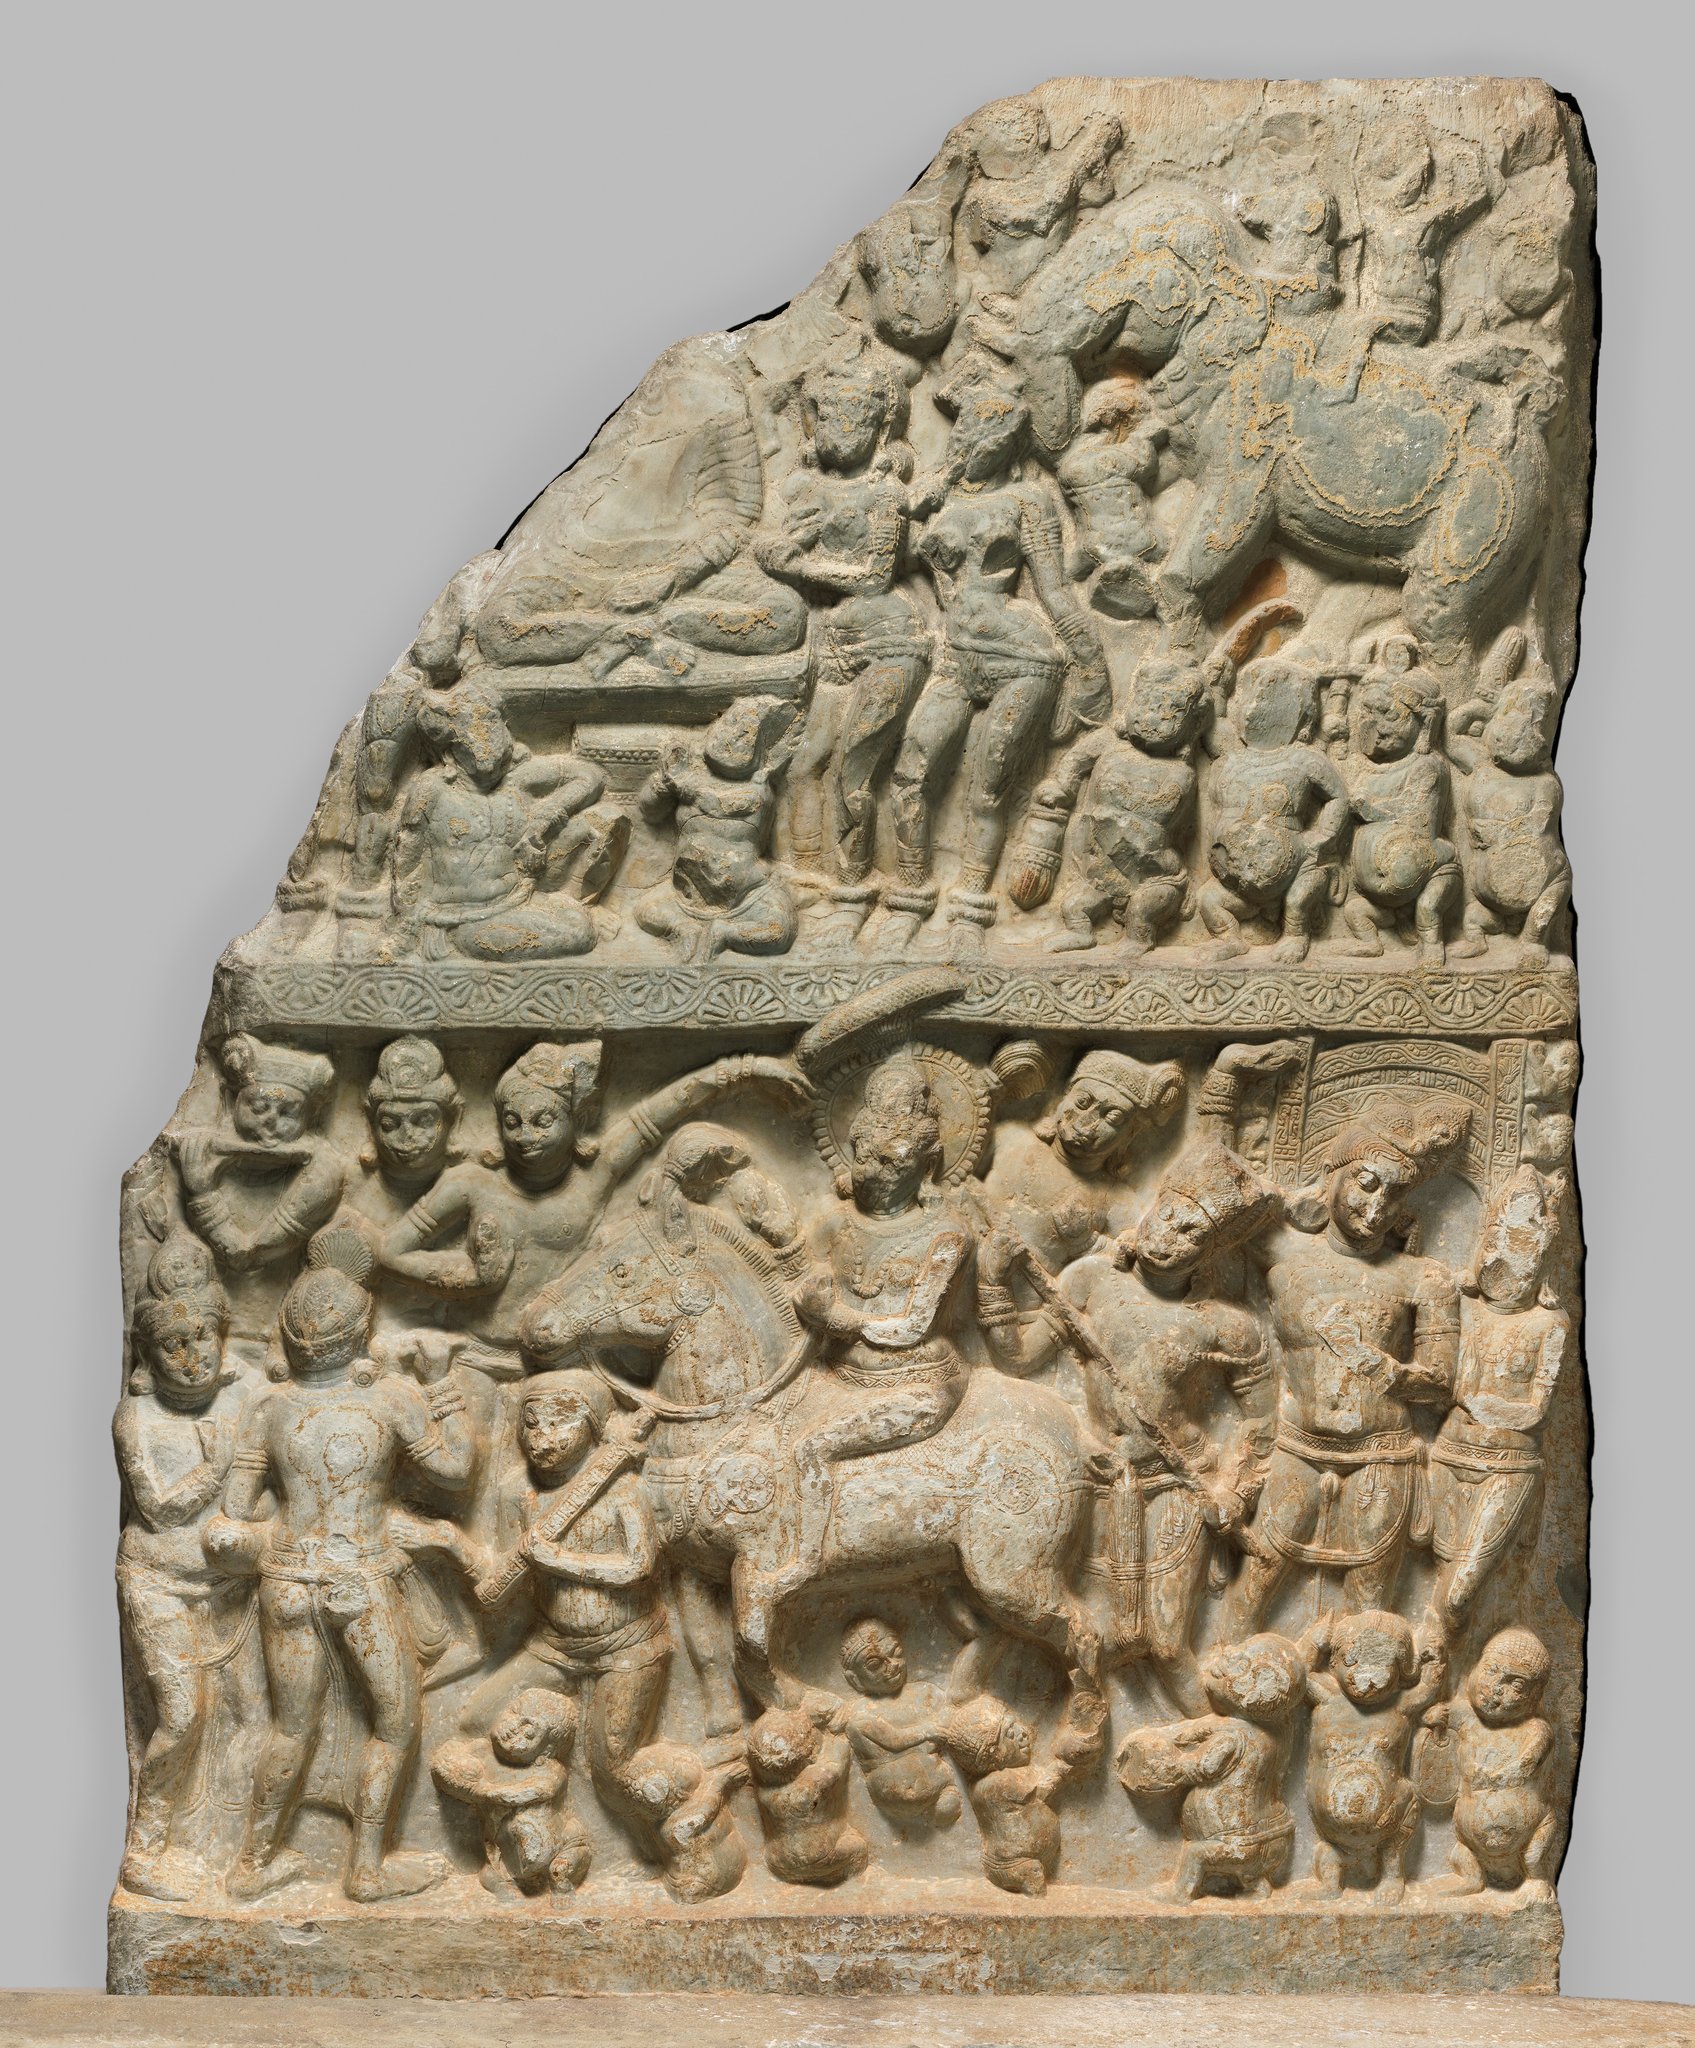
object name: relief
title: Drum panel with scenes of the Great Departure and Temptation of the Buddha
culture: indian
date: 201-250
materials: limestone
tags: early andhra,elephants,horses,buddhism,buddha